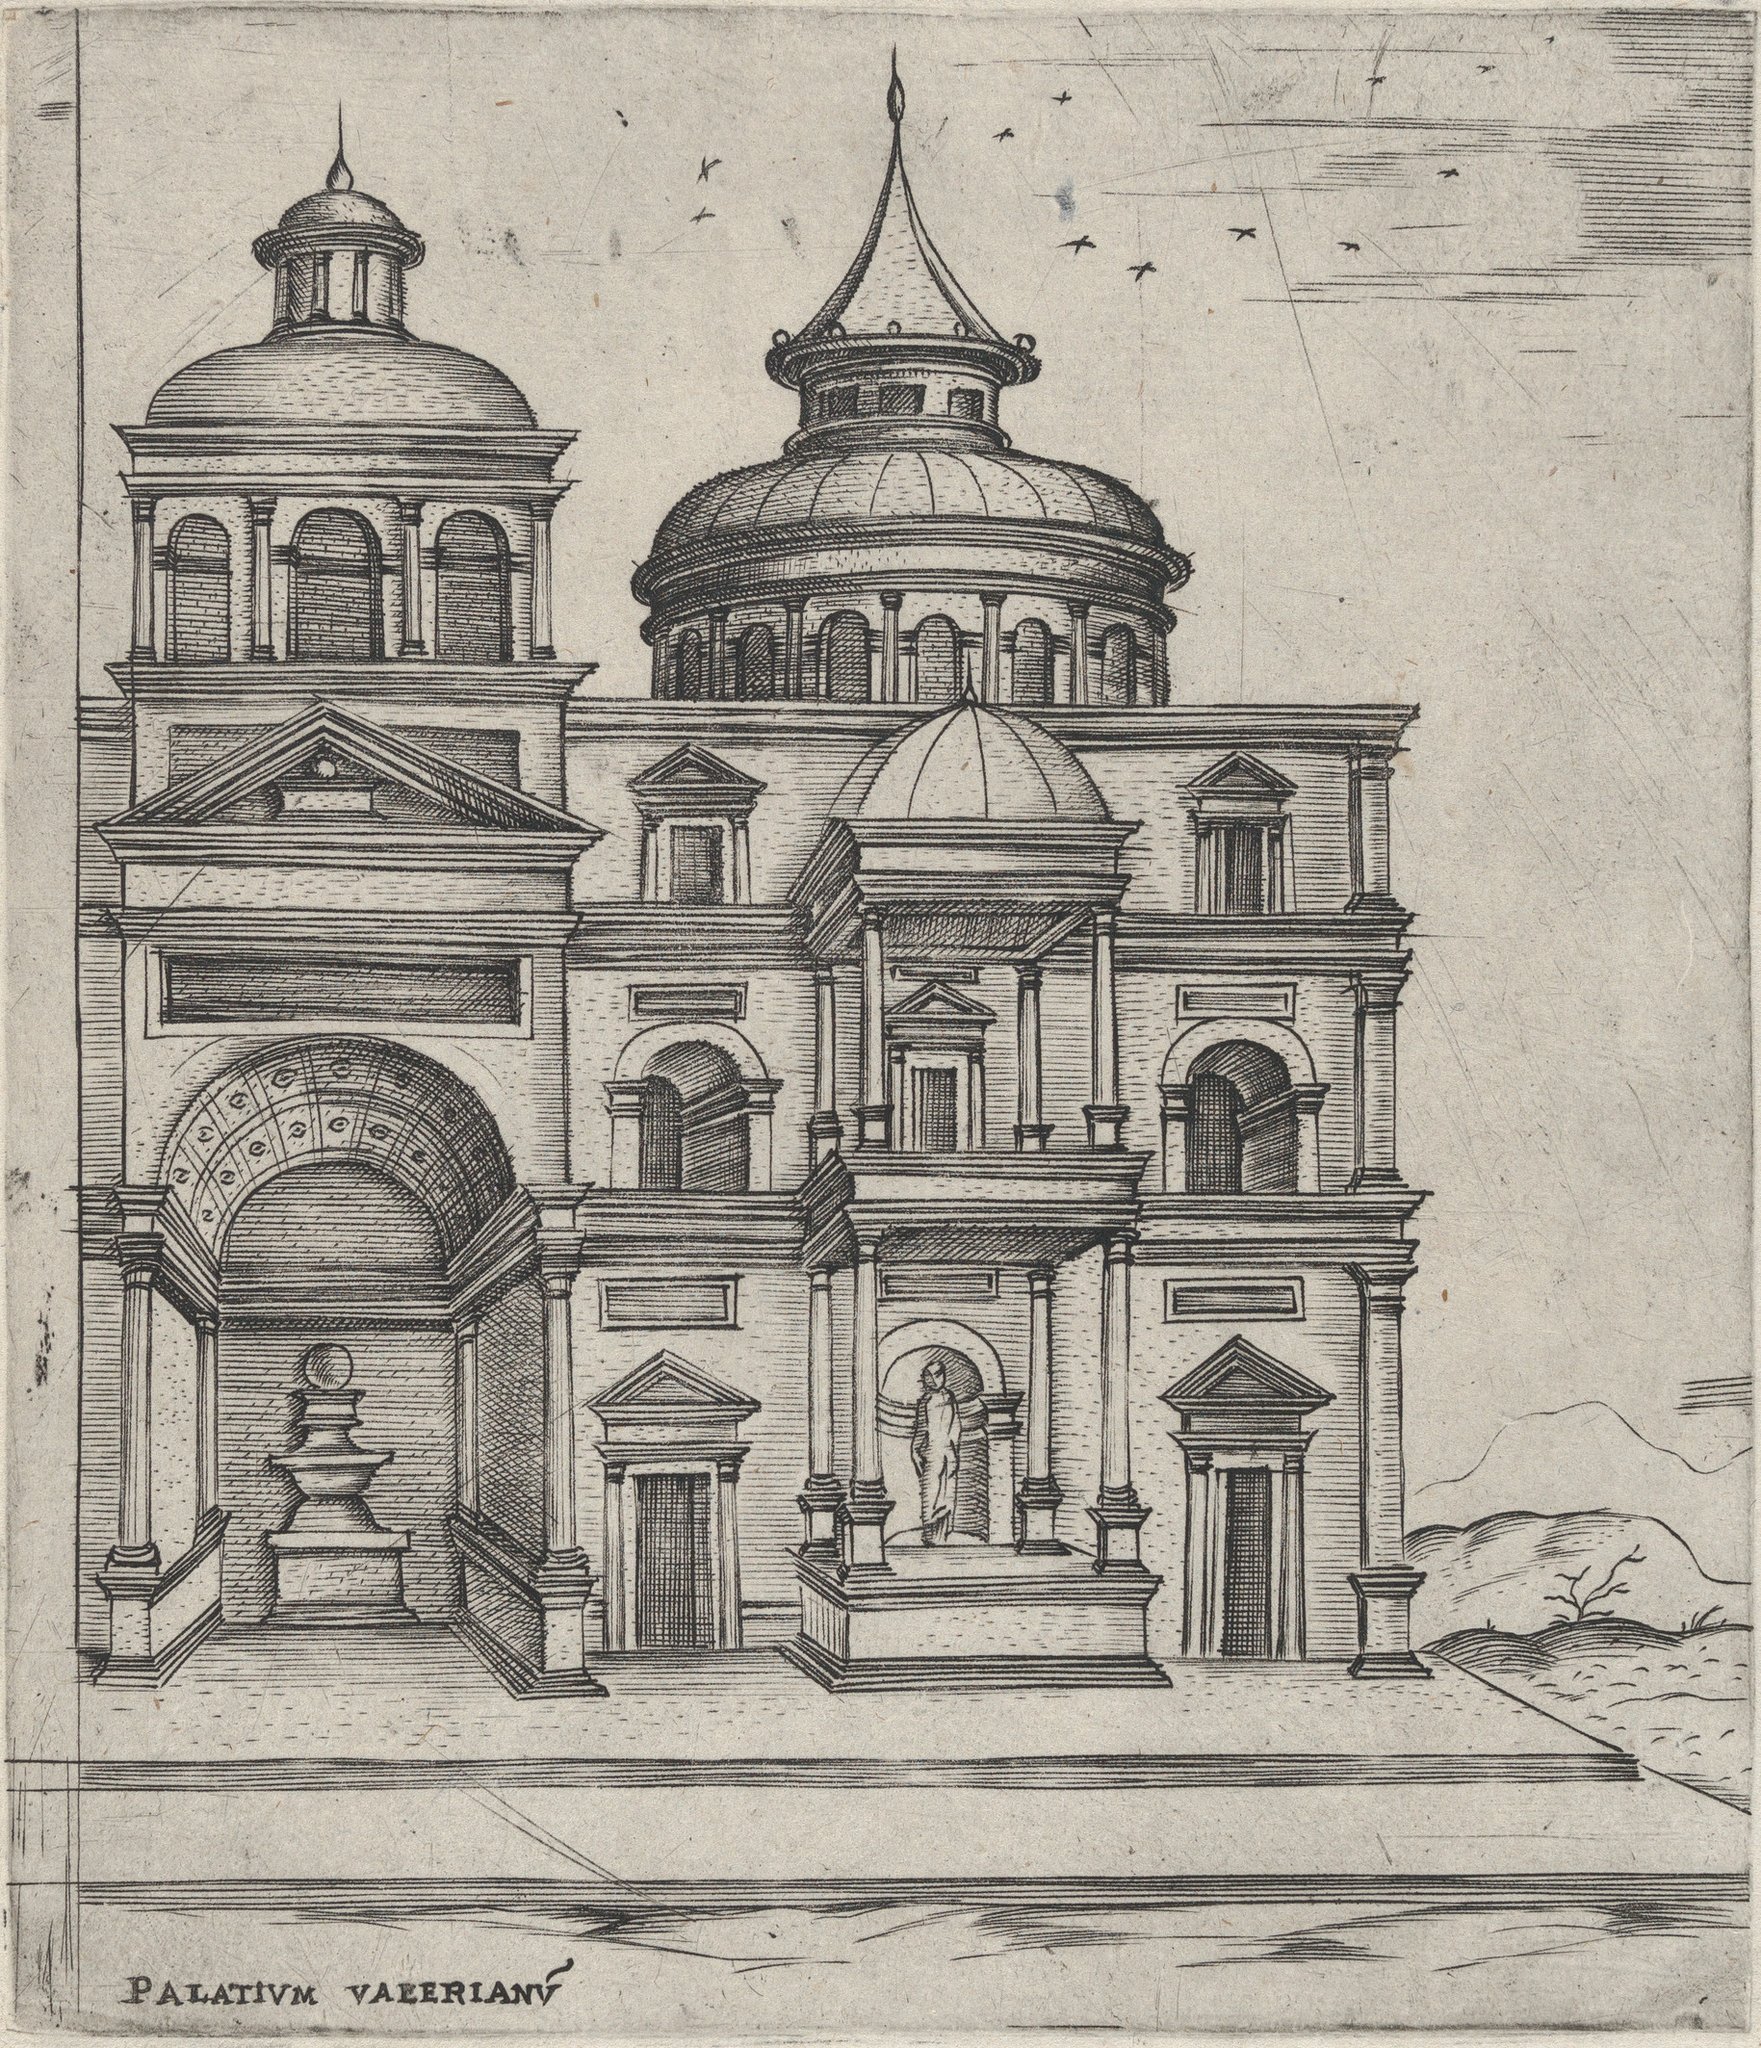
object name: print ornament architecture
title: Palatium Valerianu[m], from a Series of 24 Depicting (Reconstructed) Buildings from Roman Antiquity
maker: anonymous, italian, 16th century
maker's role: artist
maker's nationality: italian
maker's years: 1500-1600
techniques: engraving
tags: architecture,buildings